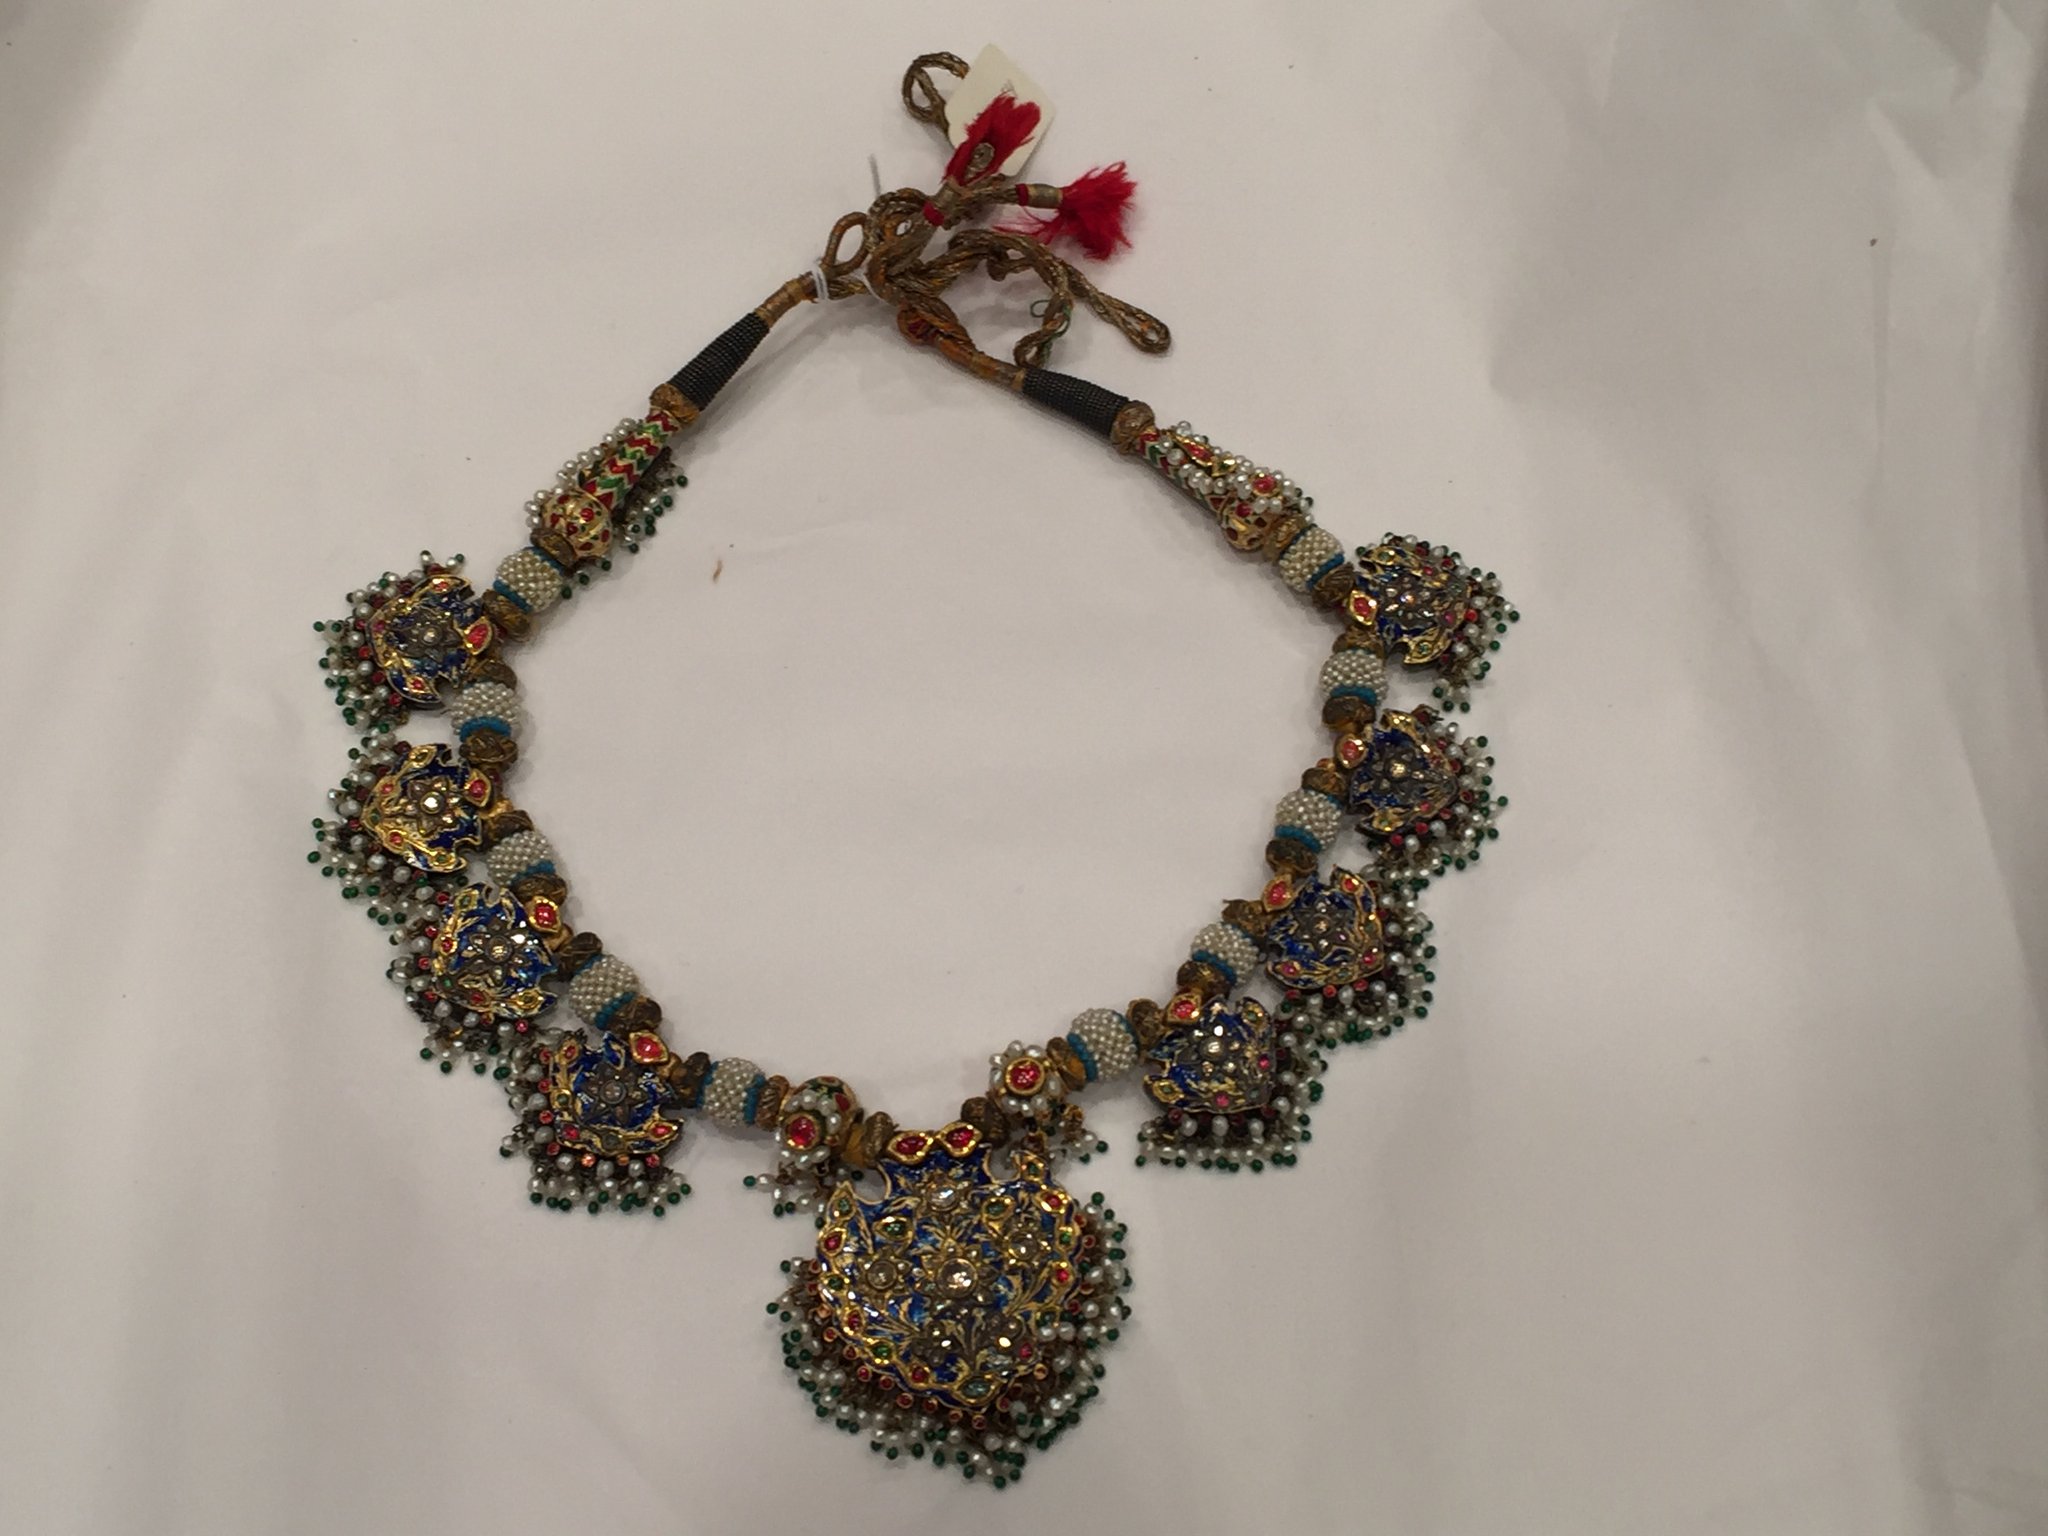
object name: necklace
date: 1701-1800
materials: gold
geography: india